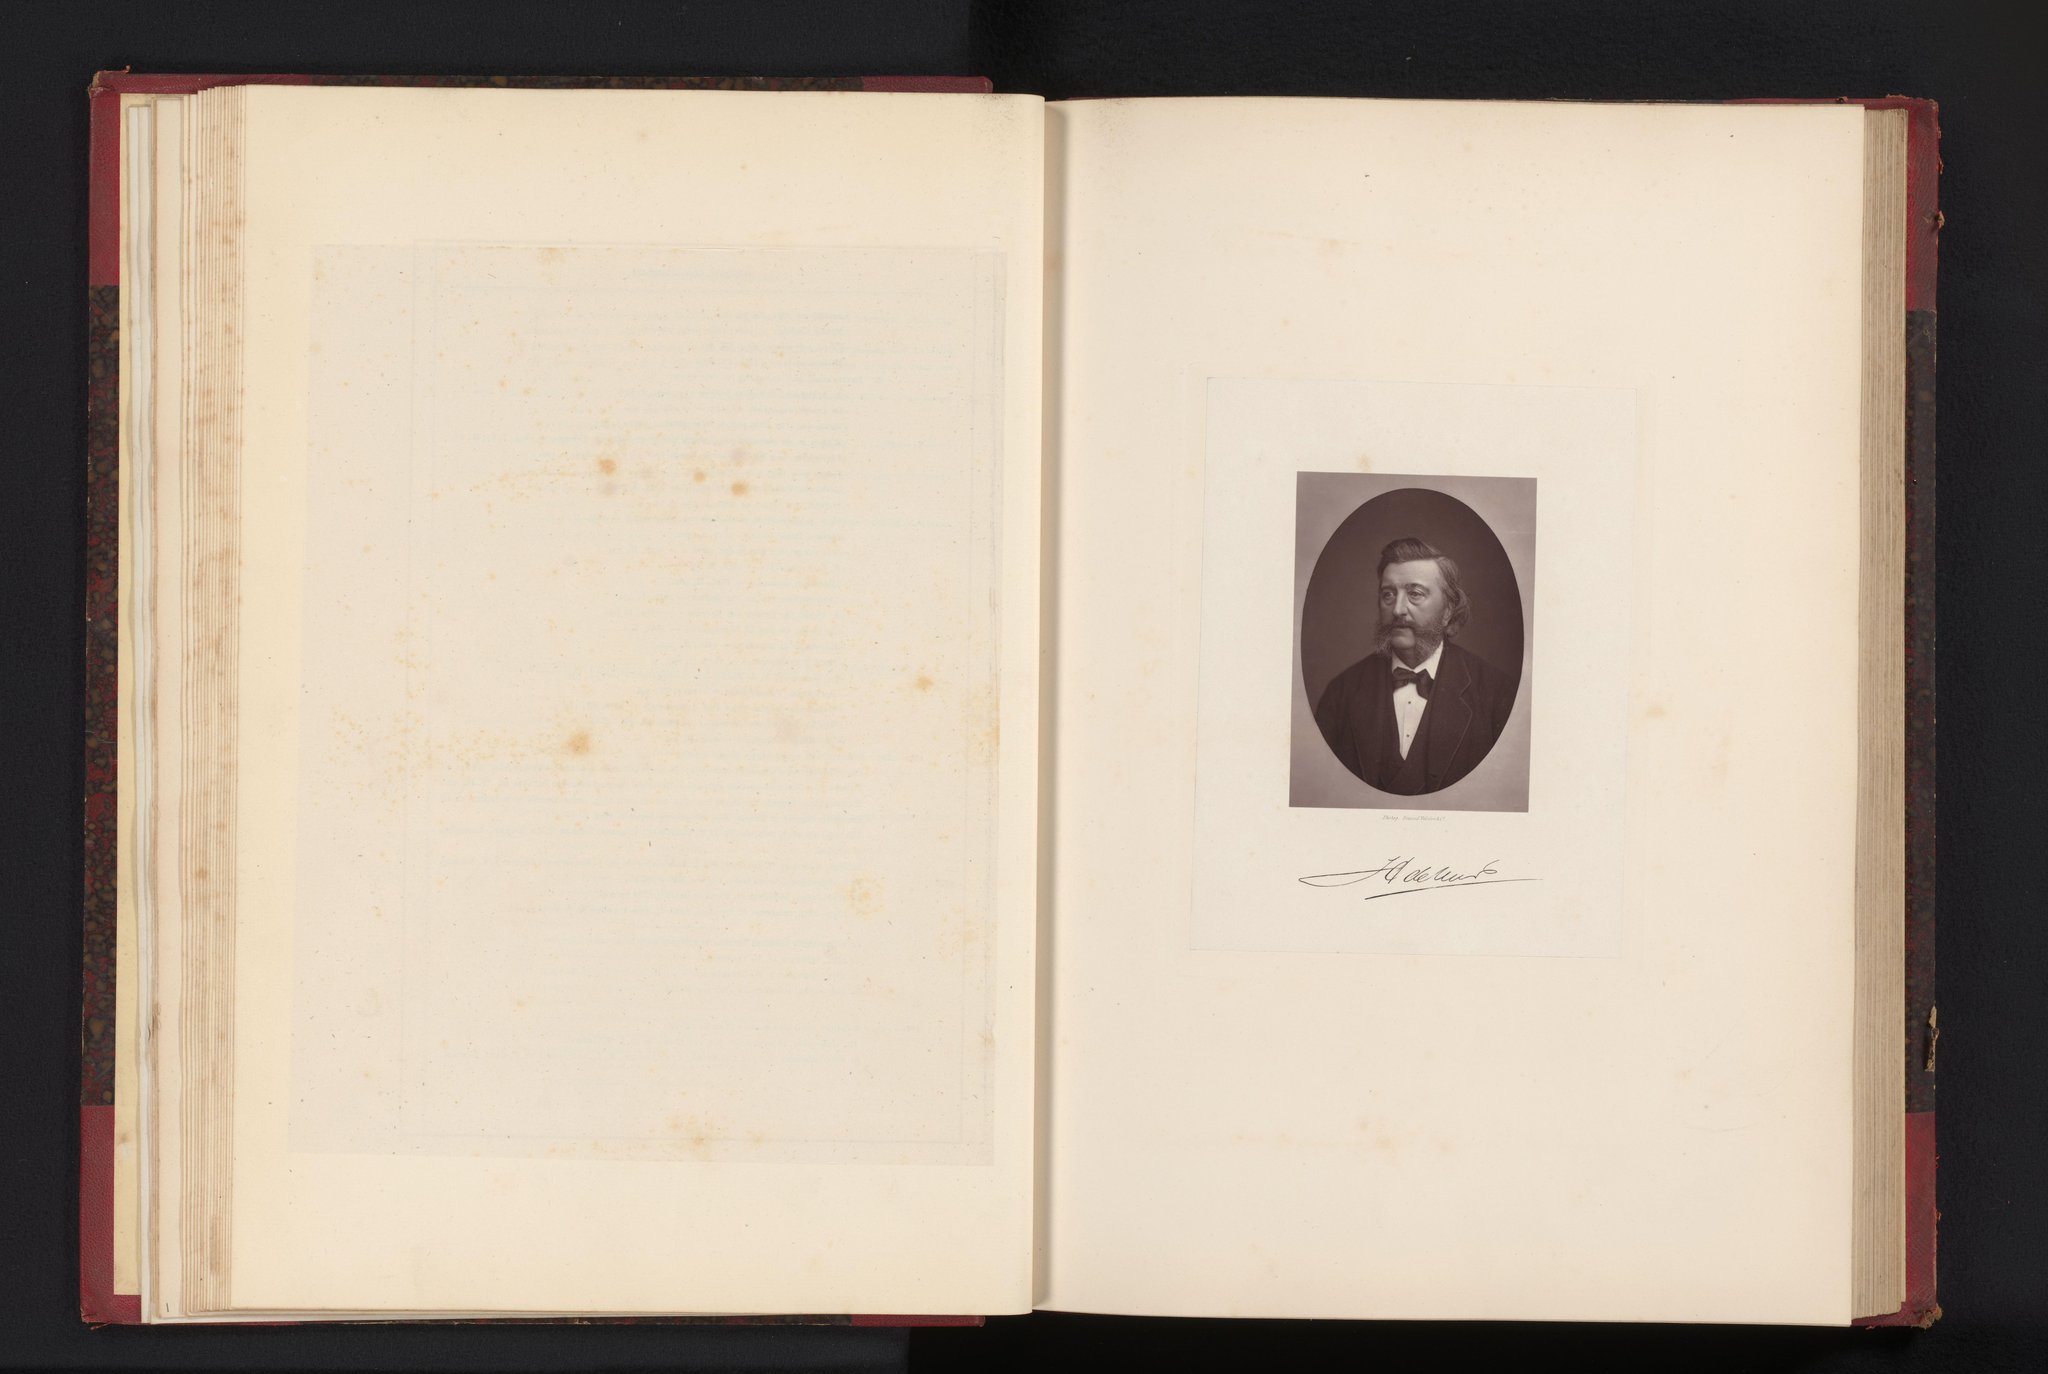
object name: photomechanical print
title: Portret van Hendrik de Veer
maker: Anonymous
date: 1878-1887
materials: paper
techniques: woodburytype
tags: historical persons, writer, poet, author